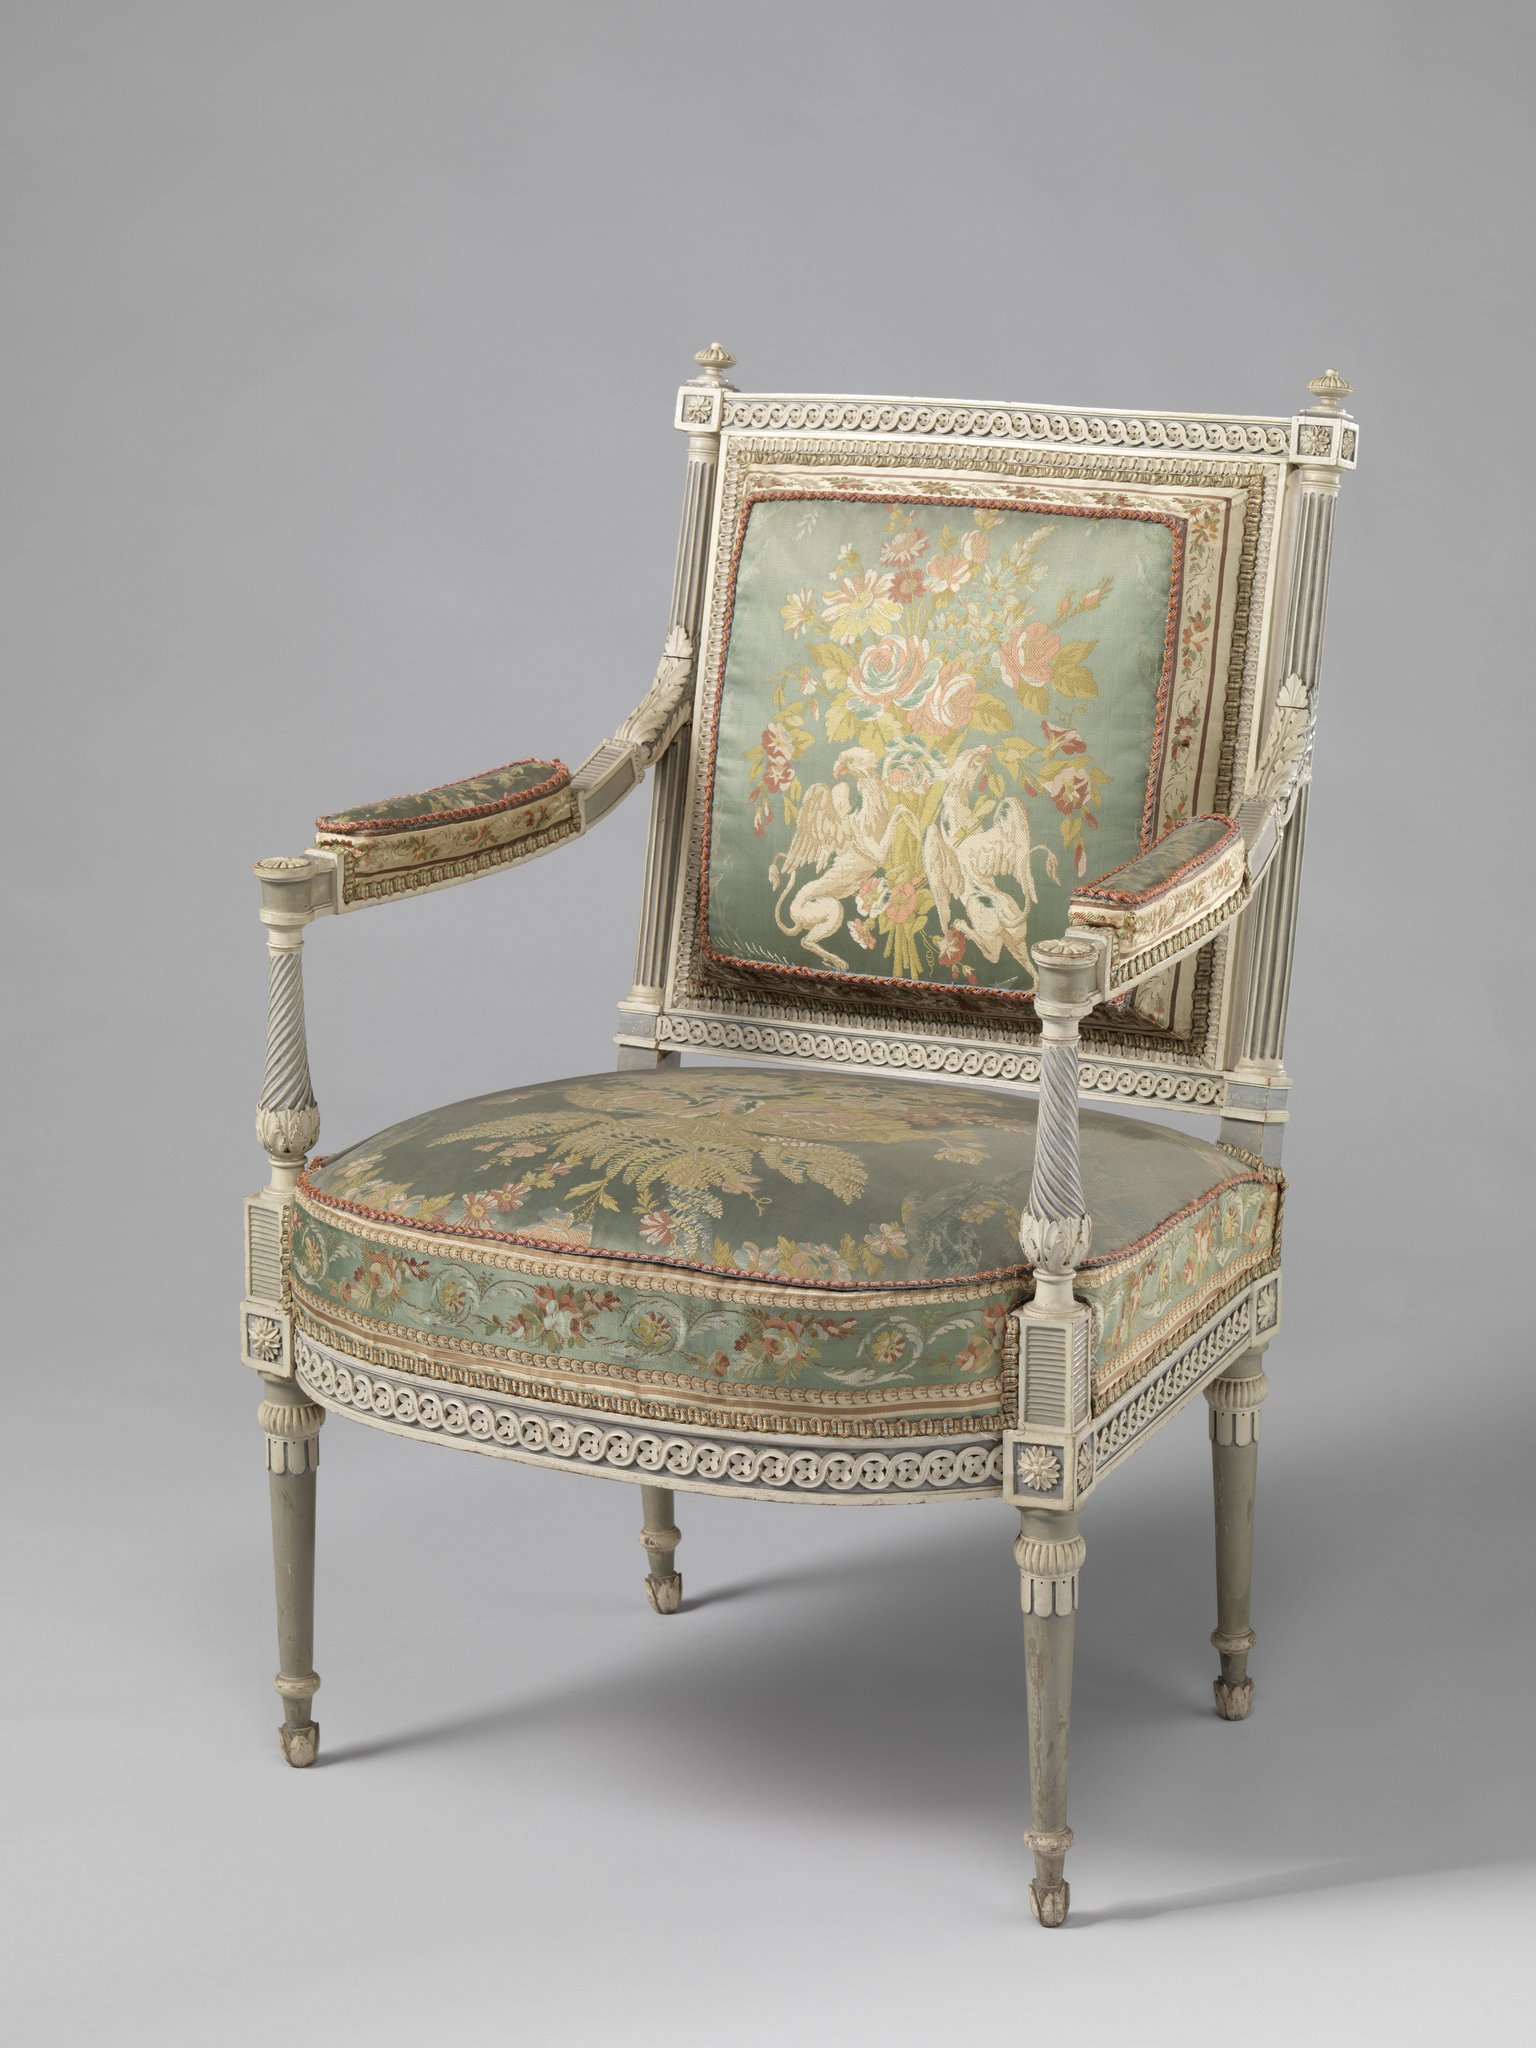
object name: armchair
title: Armstoel Kops-ameublement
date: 1793-1795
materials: wood, paint, silk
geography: amsterdam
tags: griffin (lion/eagle); 'griffo' (ripa), flowers ~ ornament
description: Armstoel uit het Kops-ameublement, van wit en blauwgrijs geschilderd beukenhout. De zitregels en dorpels van het rugraam tonen gestoken vlechtband met rozetten. Vaasvormige stutten met geslingerde cannelures steunen de armleggers met kussens, die met een acanthusblad in de Toscaanse zuilen van het rugraam overlopen. De bekleding toont op lichtblauwe satijnen grond florale motieven, op de rug gehouden door griffioenen. Besteld voor het pand Nieuwe Gracht 74, Haarlem. Zie: bk-15614, 15615-a/p, 15616-a/b.